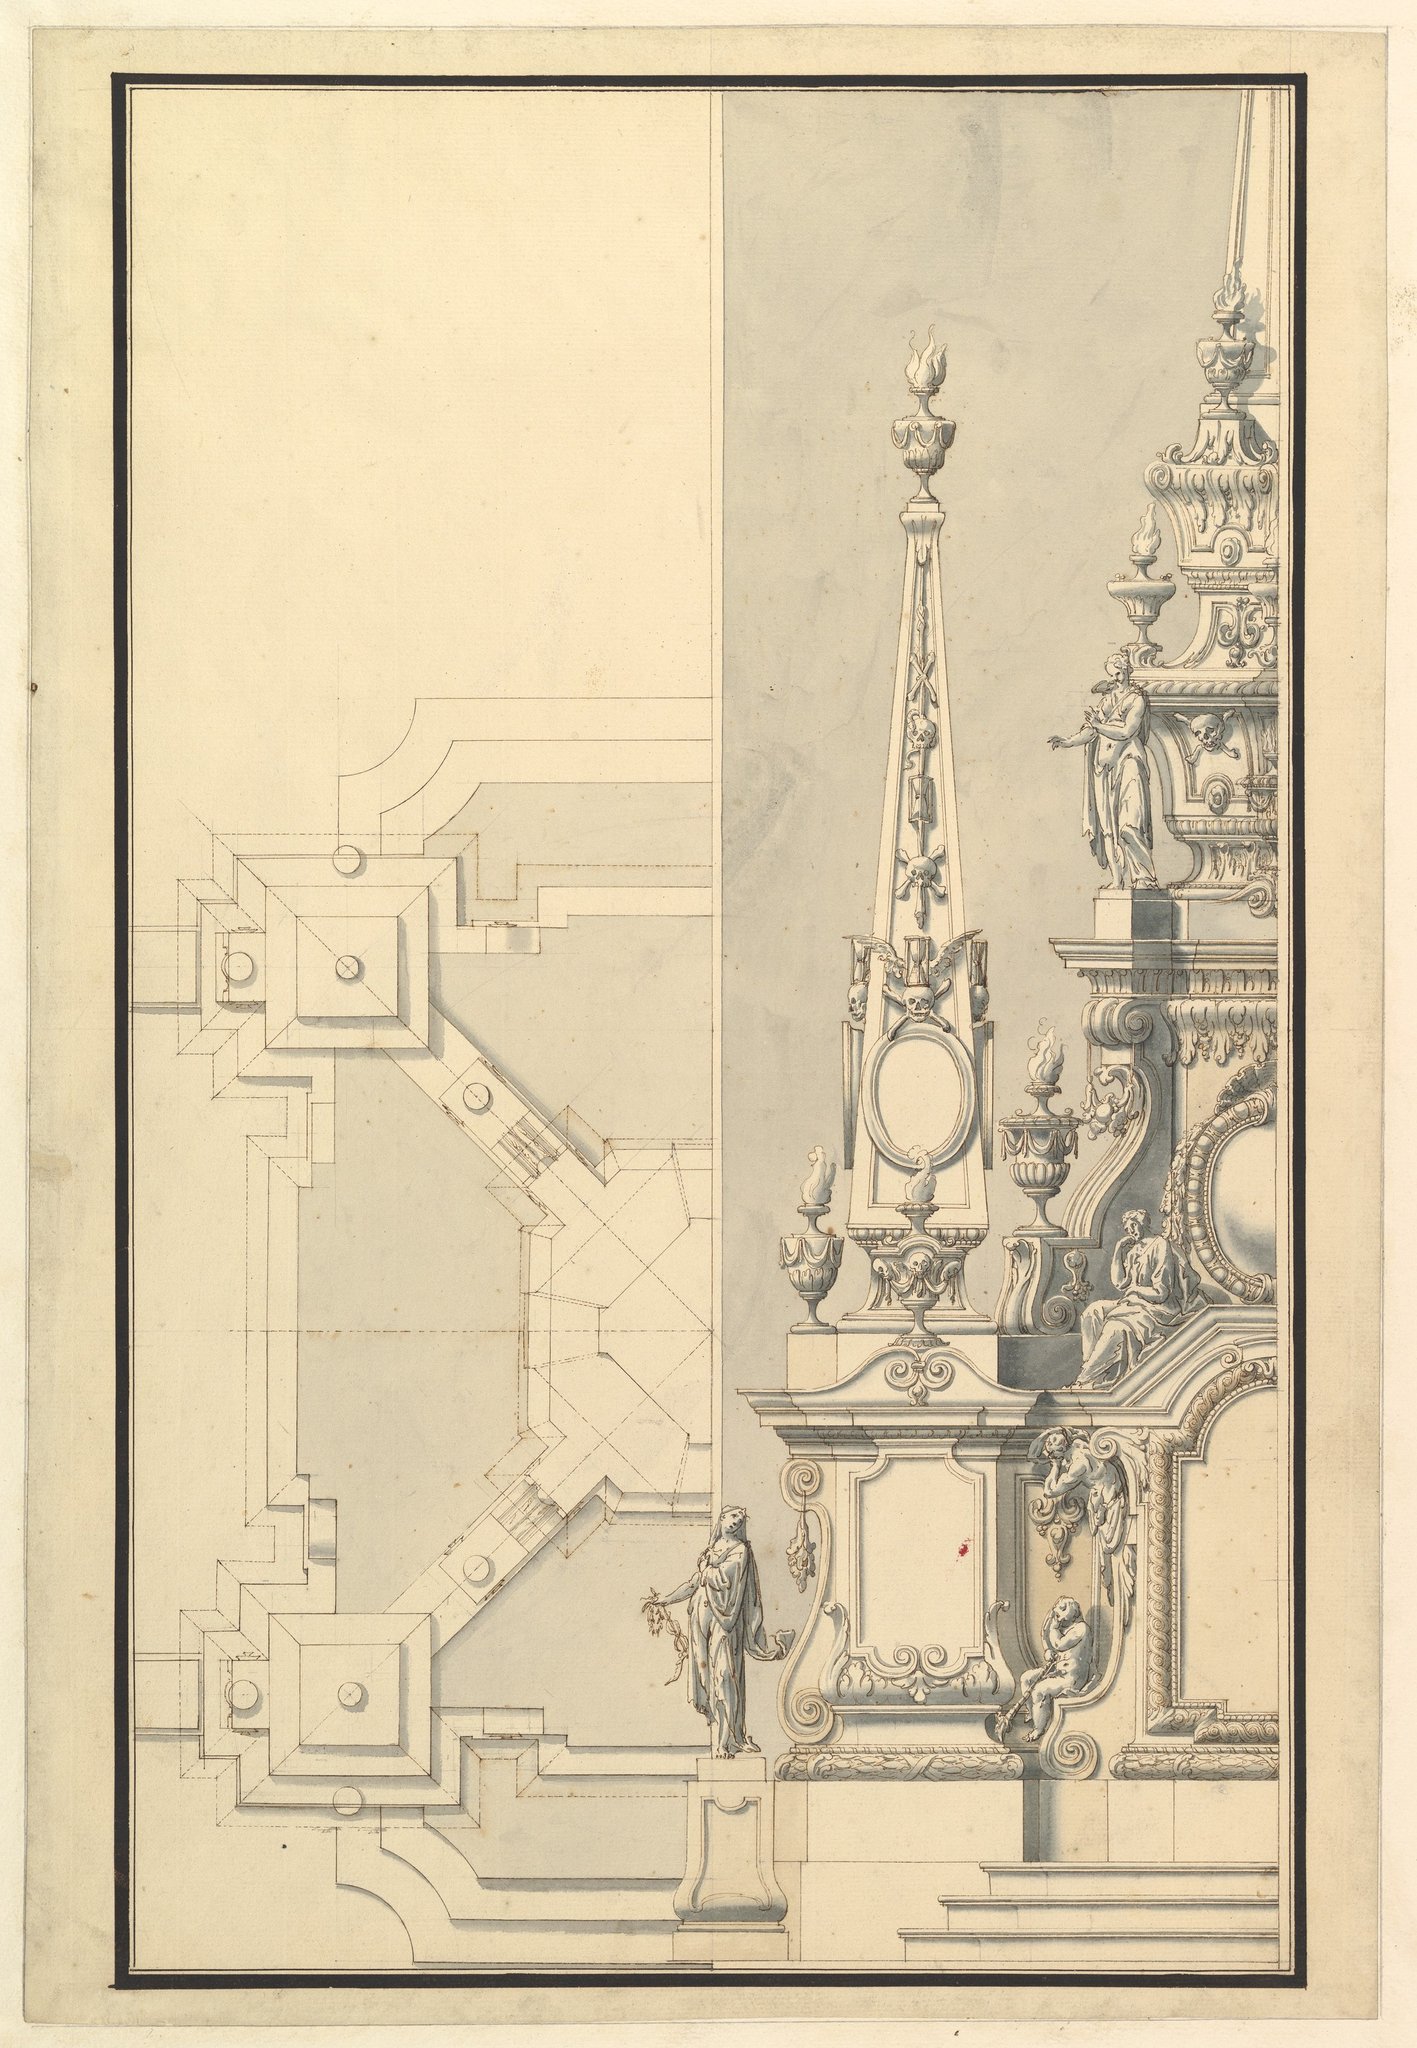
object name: drawing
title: Half Ground Plan and Half Elevation for a Catafalque for a Prince of Hanover, probably Ernst August (1674–1728)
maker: giuseppe galli bibiena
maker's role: artist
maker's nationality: italian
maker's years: 1696-1756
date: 1696-1756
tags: architecture